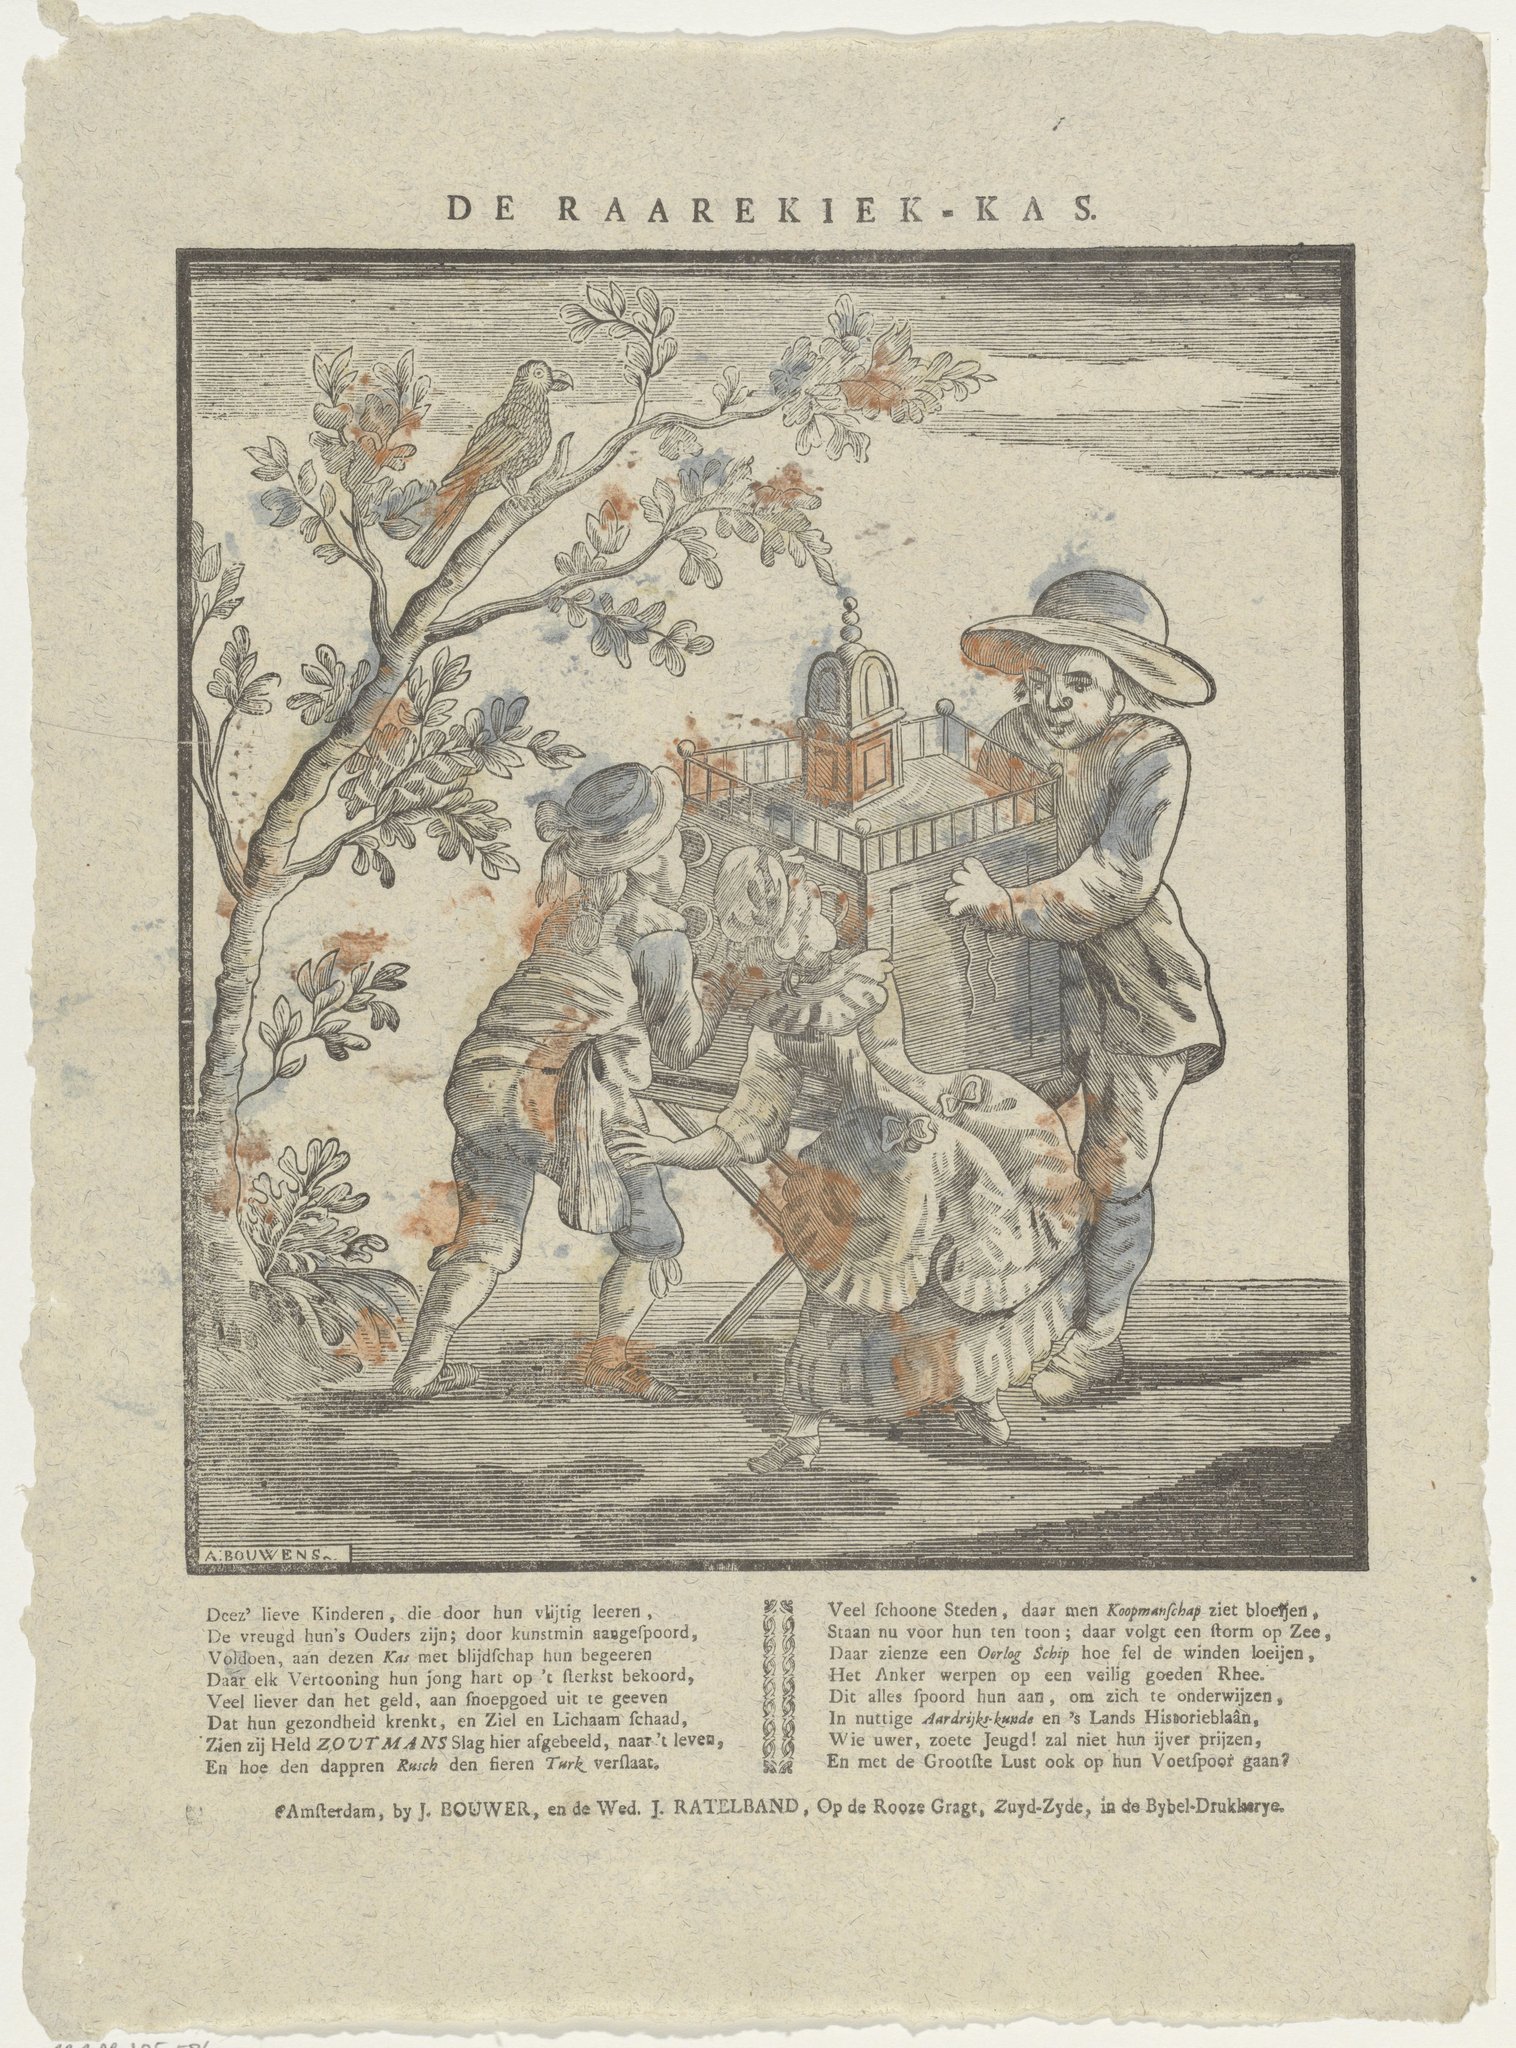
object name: popular print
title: De raarekiek-kas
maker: a. bouwens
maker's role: bloksnijder, houtsnijder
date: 1794-1804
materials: paper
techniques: colour, letterpress printing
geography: netherlands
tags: diorama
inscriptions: collector's mark: Lugt 2760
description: Blad met een grote voorstelling van kinderen die in een kijkkast kijken. Onder de afbeelding een vers in twee kolommen.